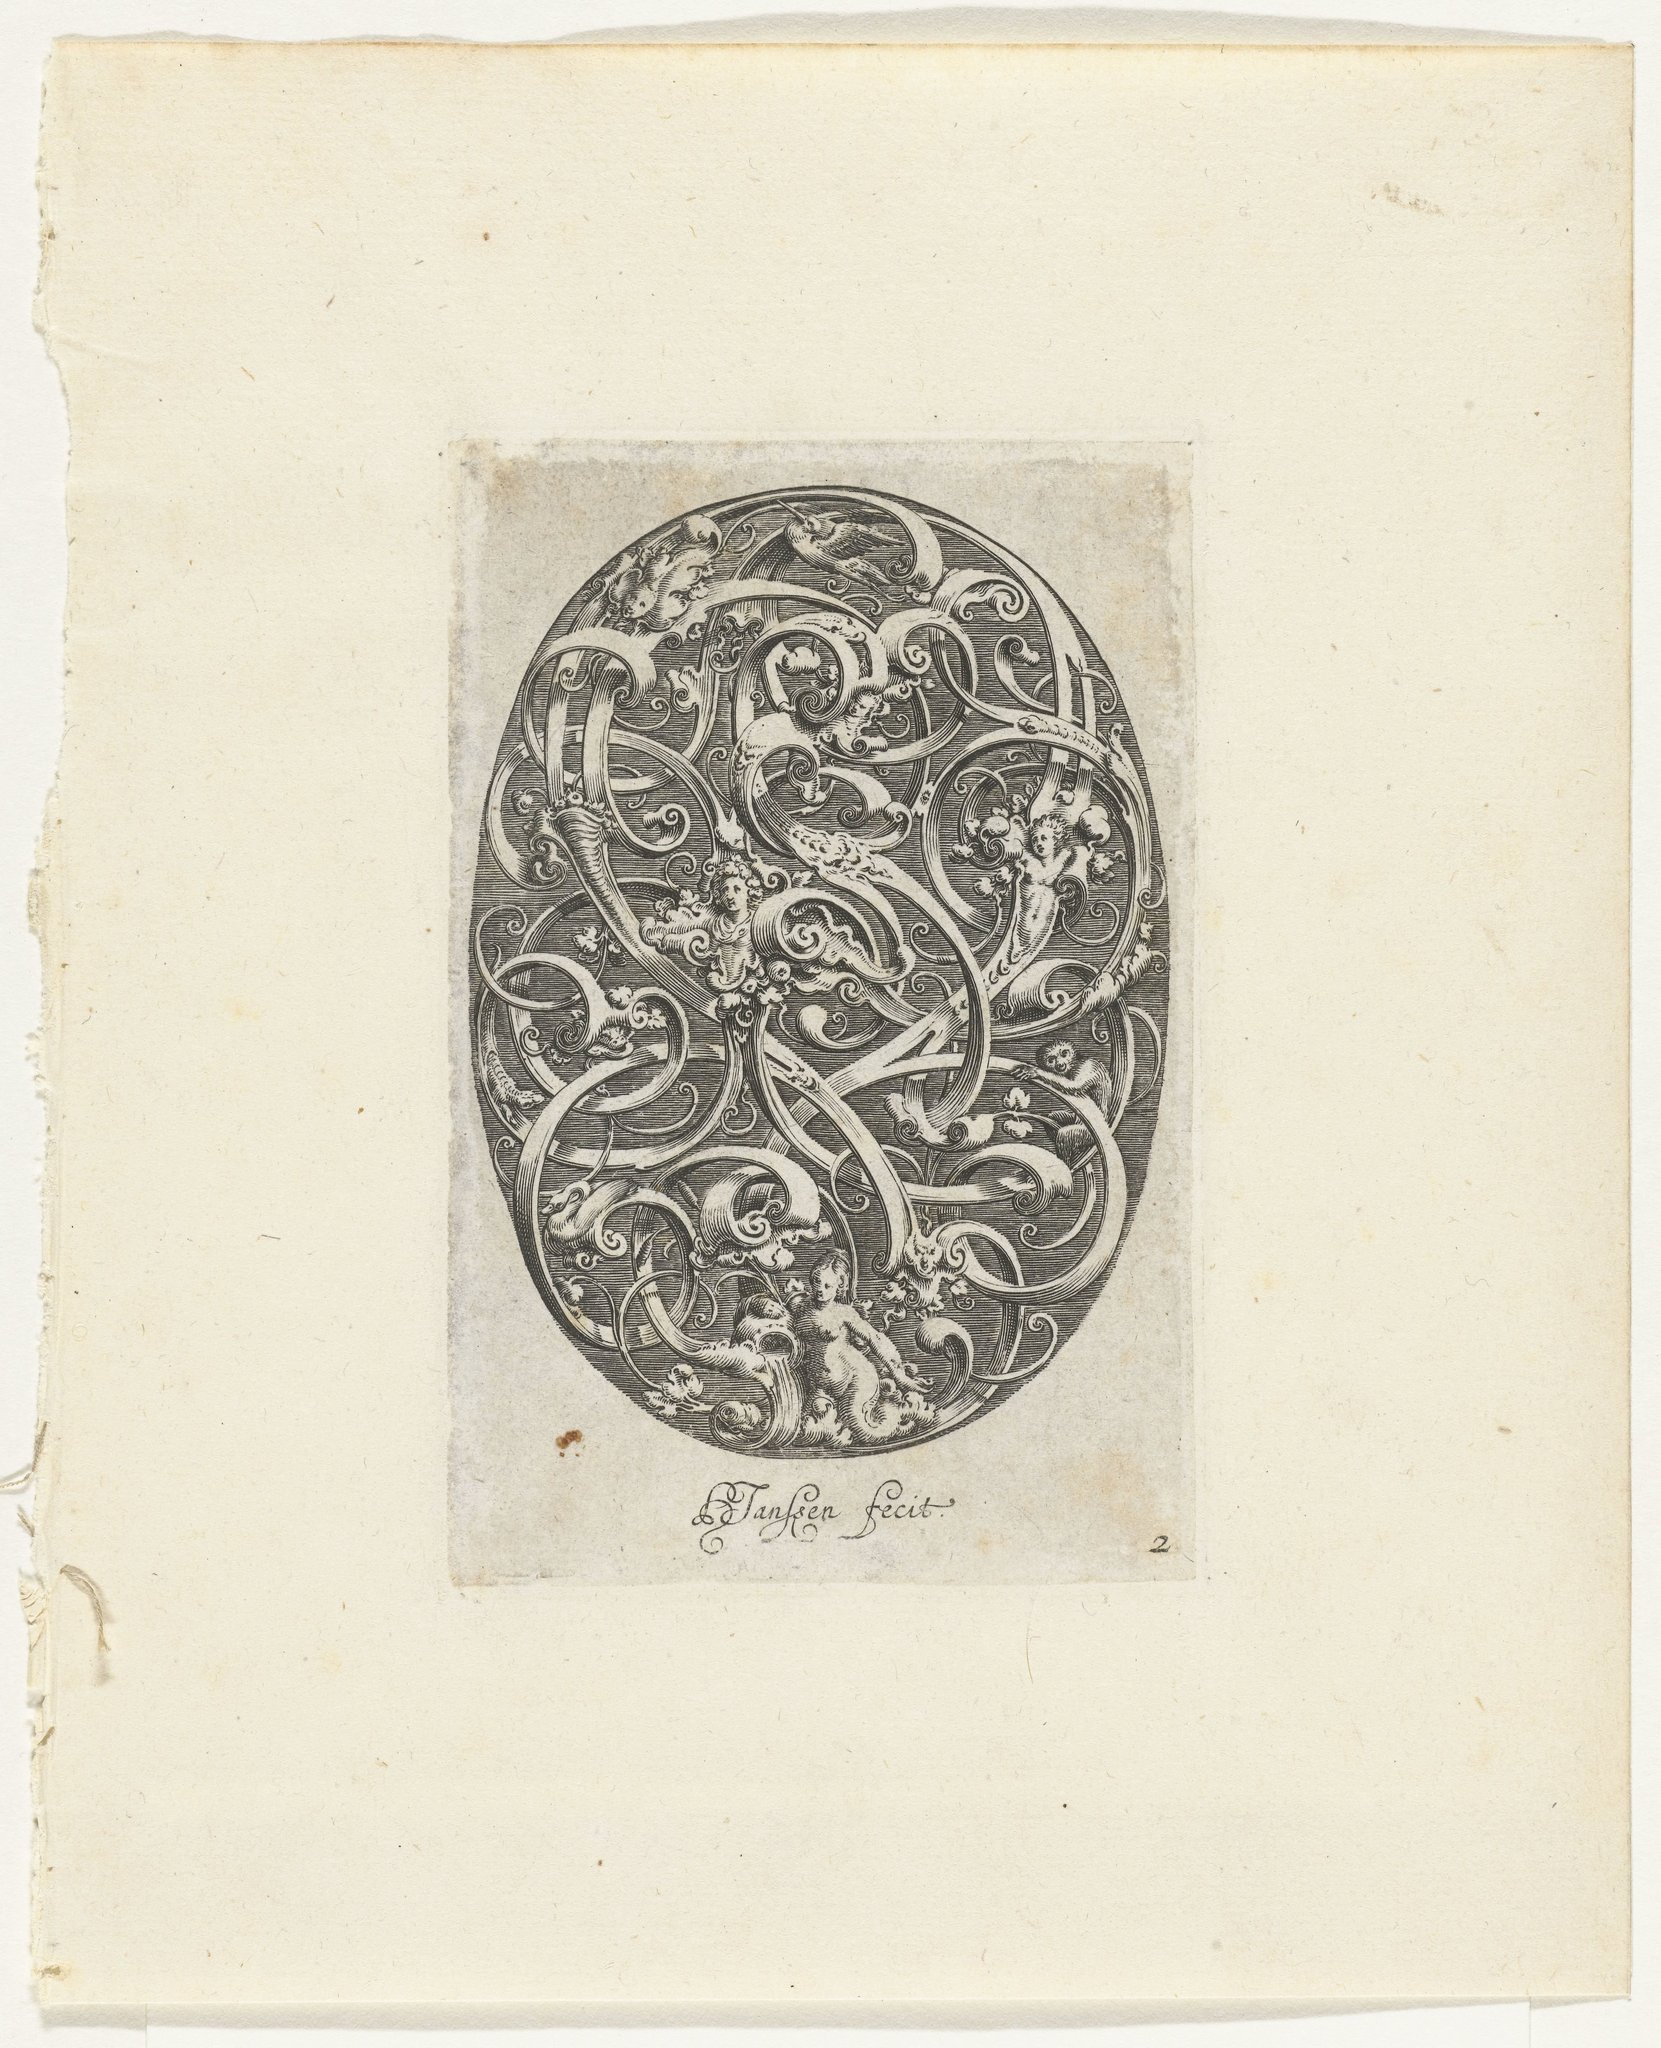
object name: ornament print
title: Aarde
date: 1615-1630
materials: paper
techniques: etching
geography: amsterdam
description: Ovaal met ornamentele ranken. Onderaan zit een nimf met een urn. Tweede editie.